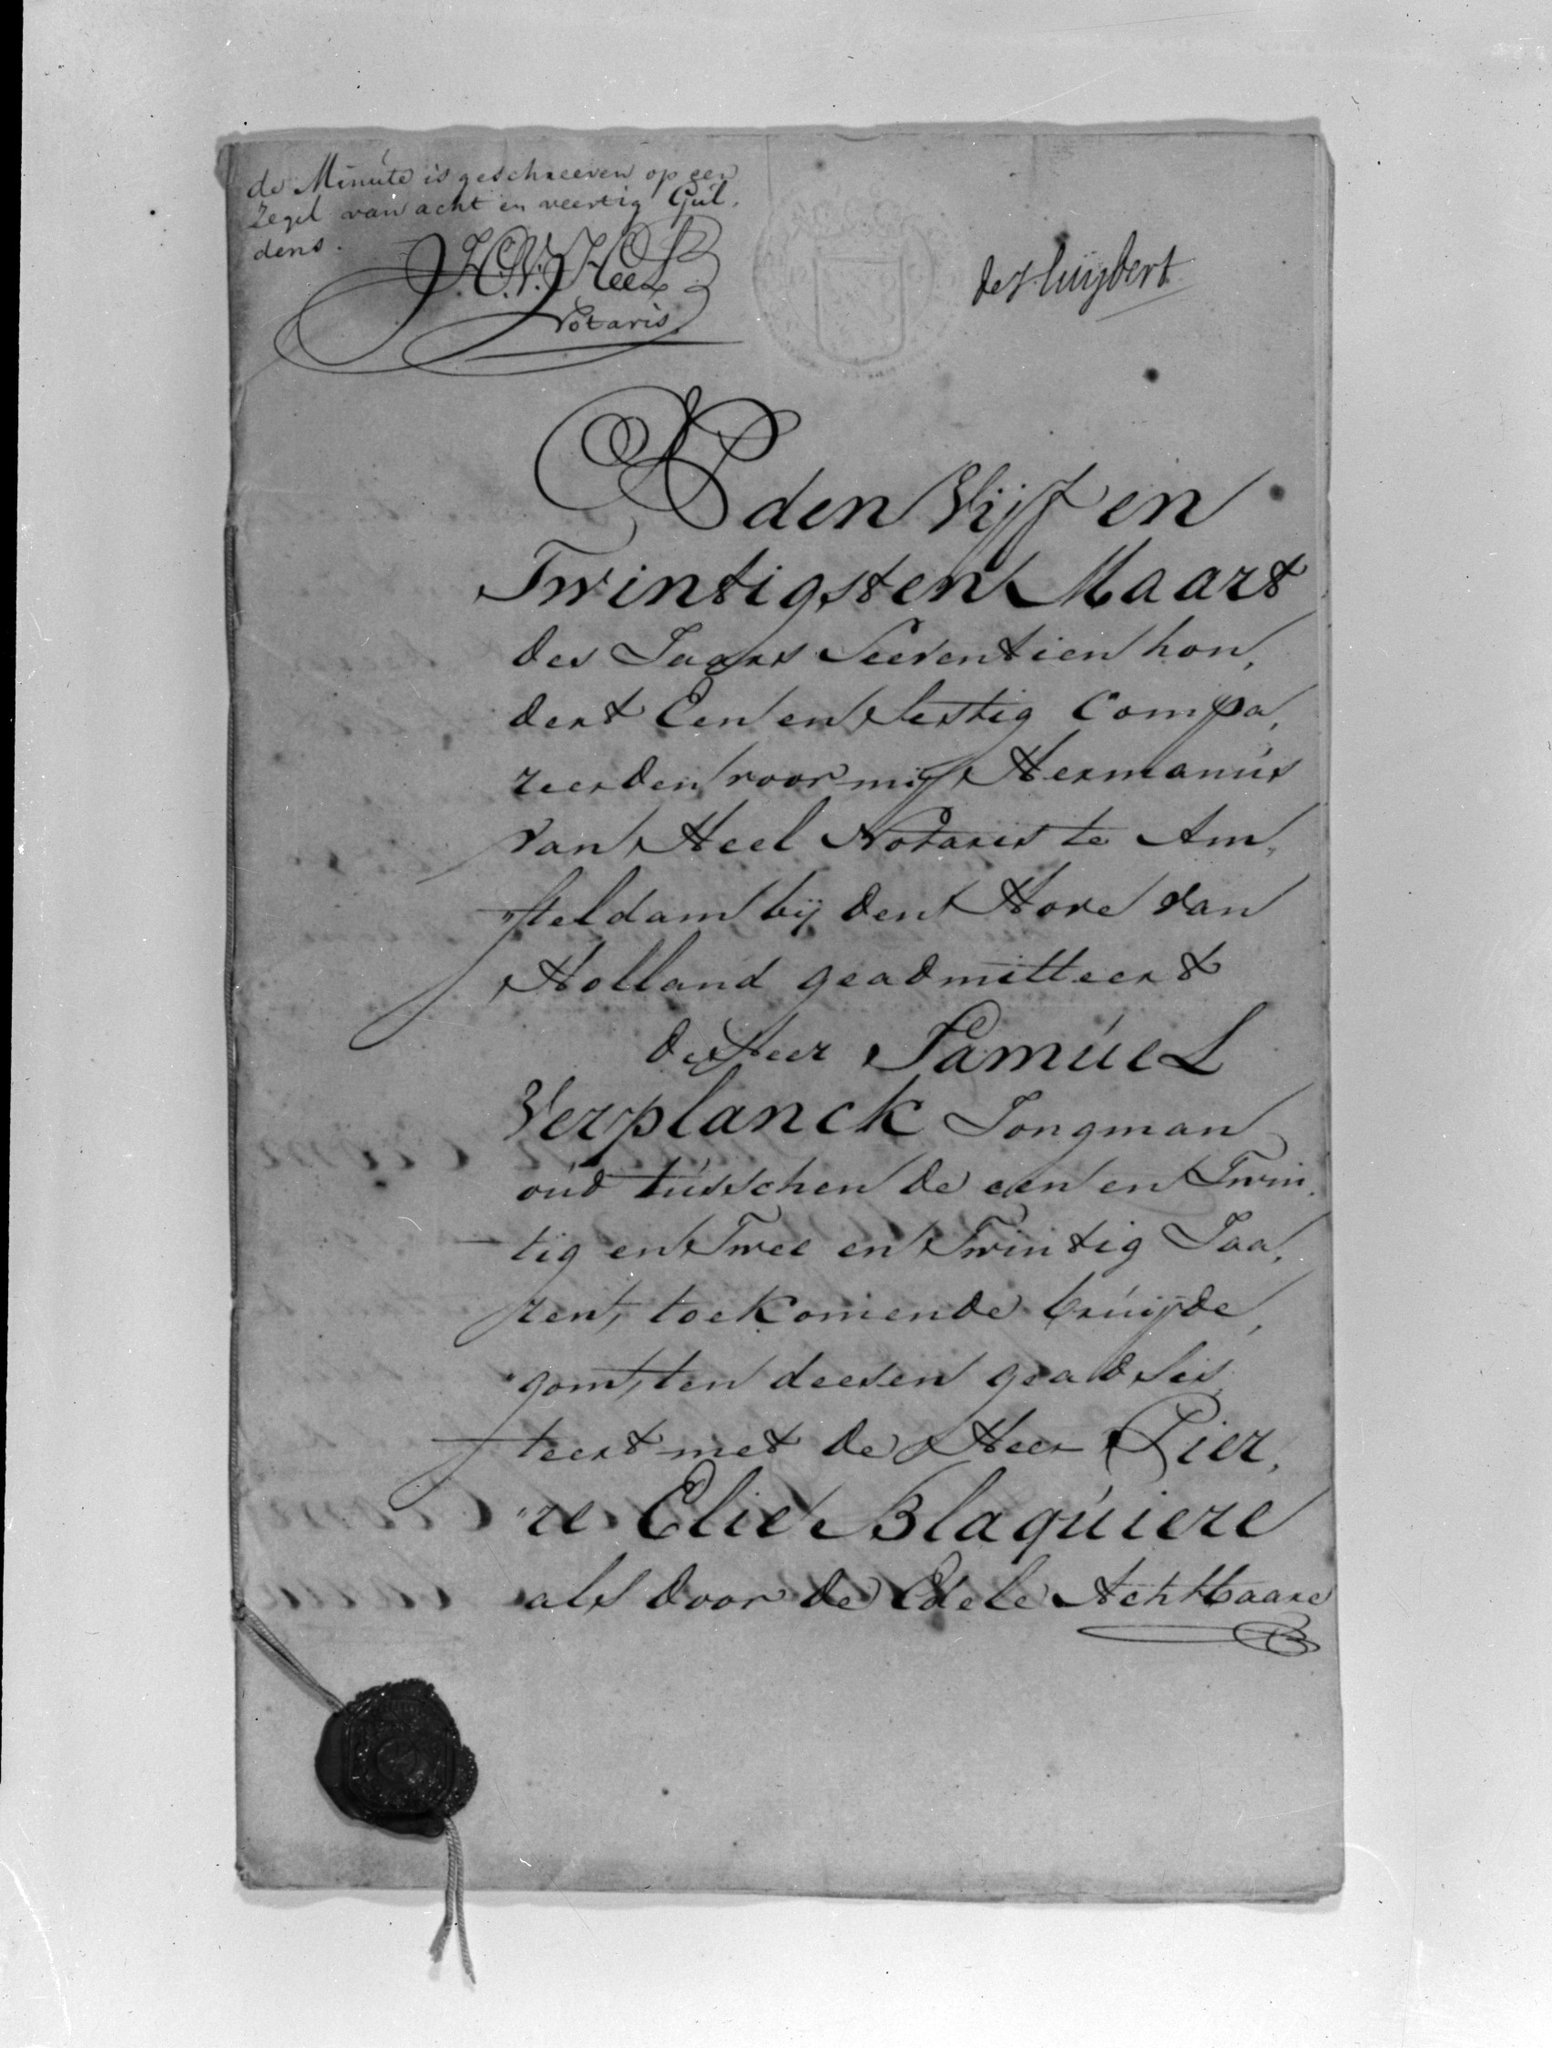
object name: marriage contract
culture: dutch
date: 1761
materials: paper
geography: netherlands